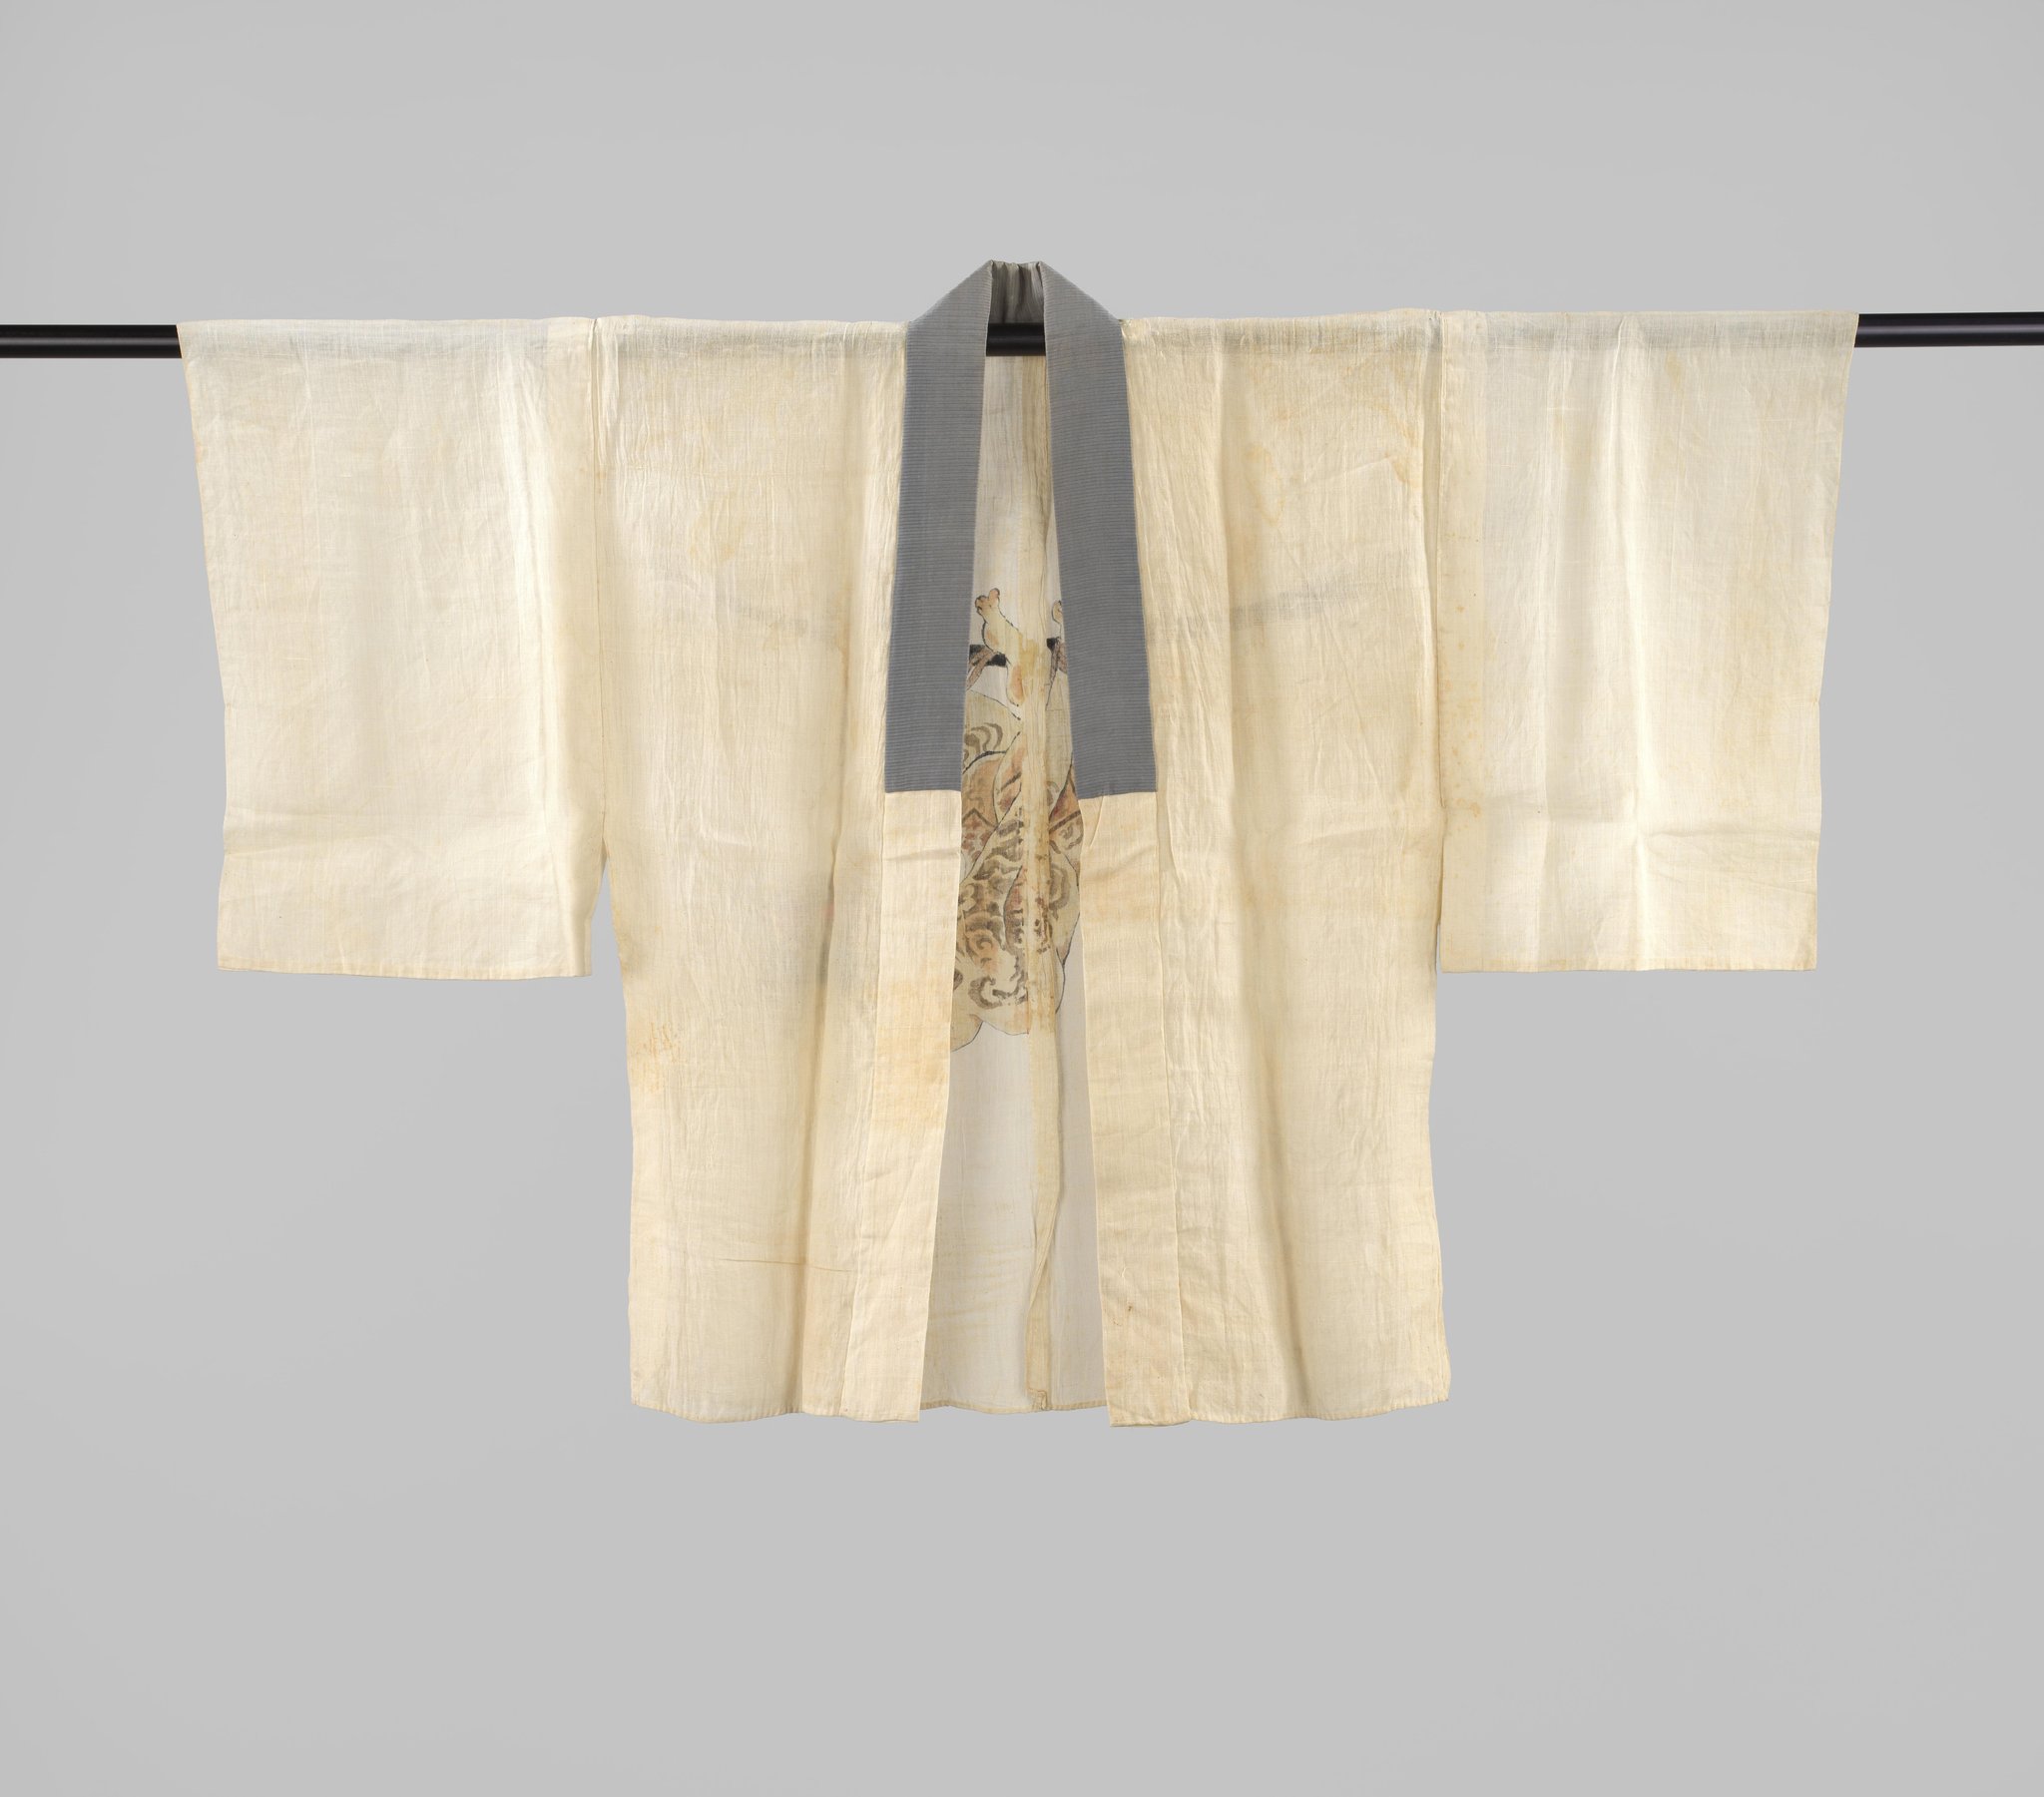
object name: kimono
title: Onderkimono voor mannen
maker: Anonymous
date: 1920-1940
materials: ink, paint, silk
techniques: weave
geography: japan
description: Naked tattood young woman suspended in bondage from a horizontal pole. Man's hanjuban. No crests.